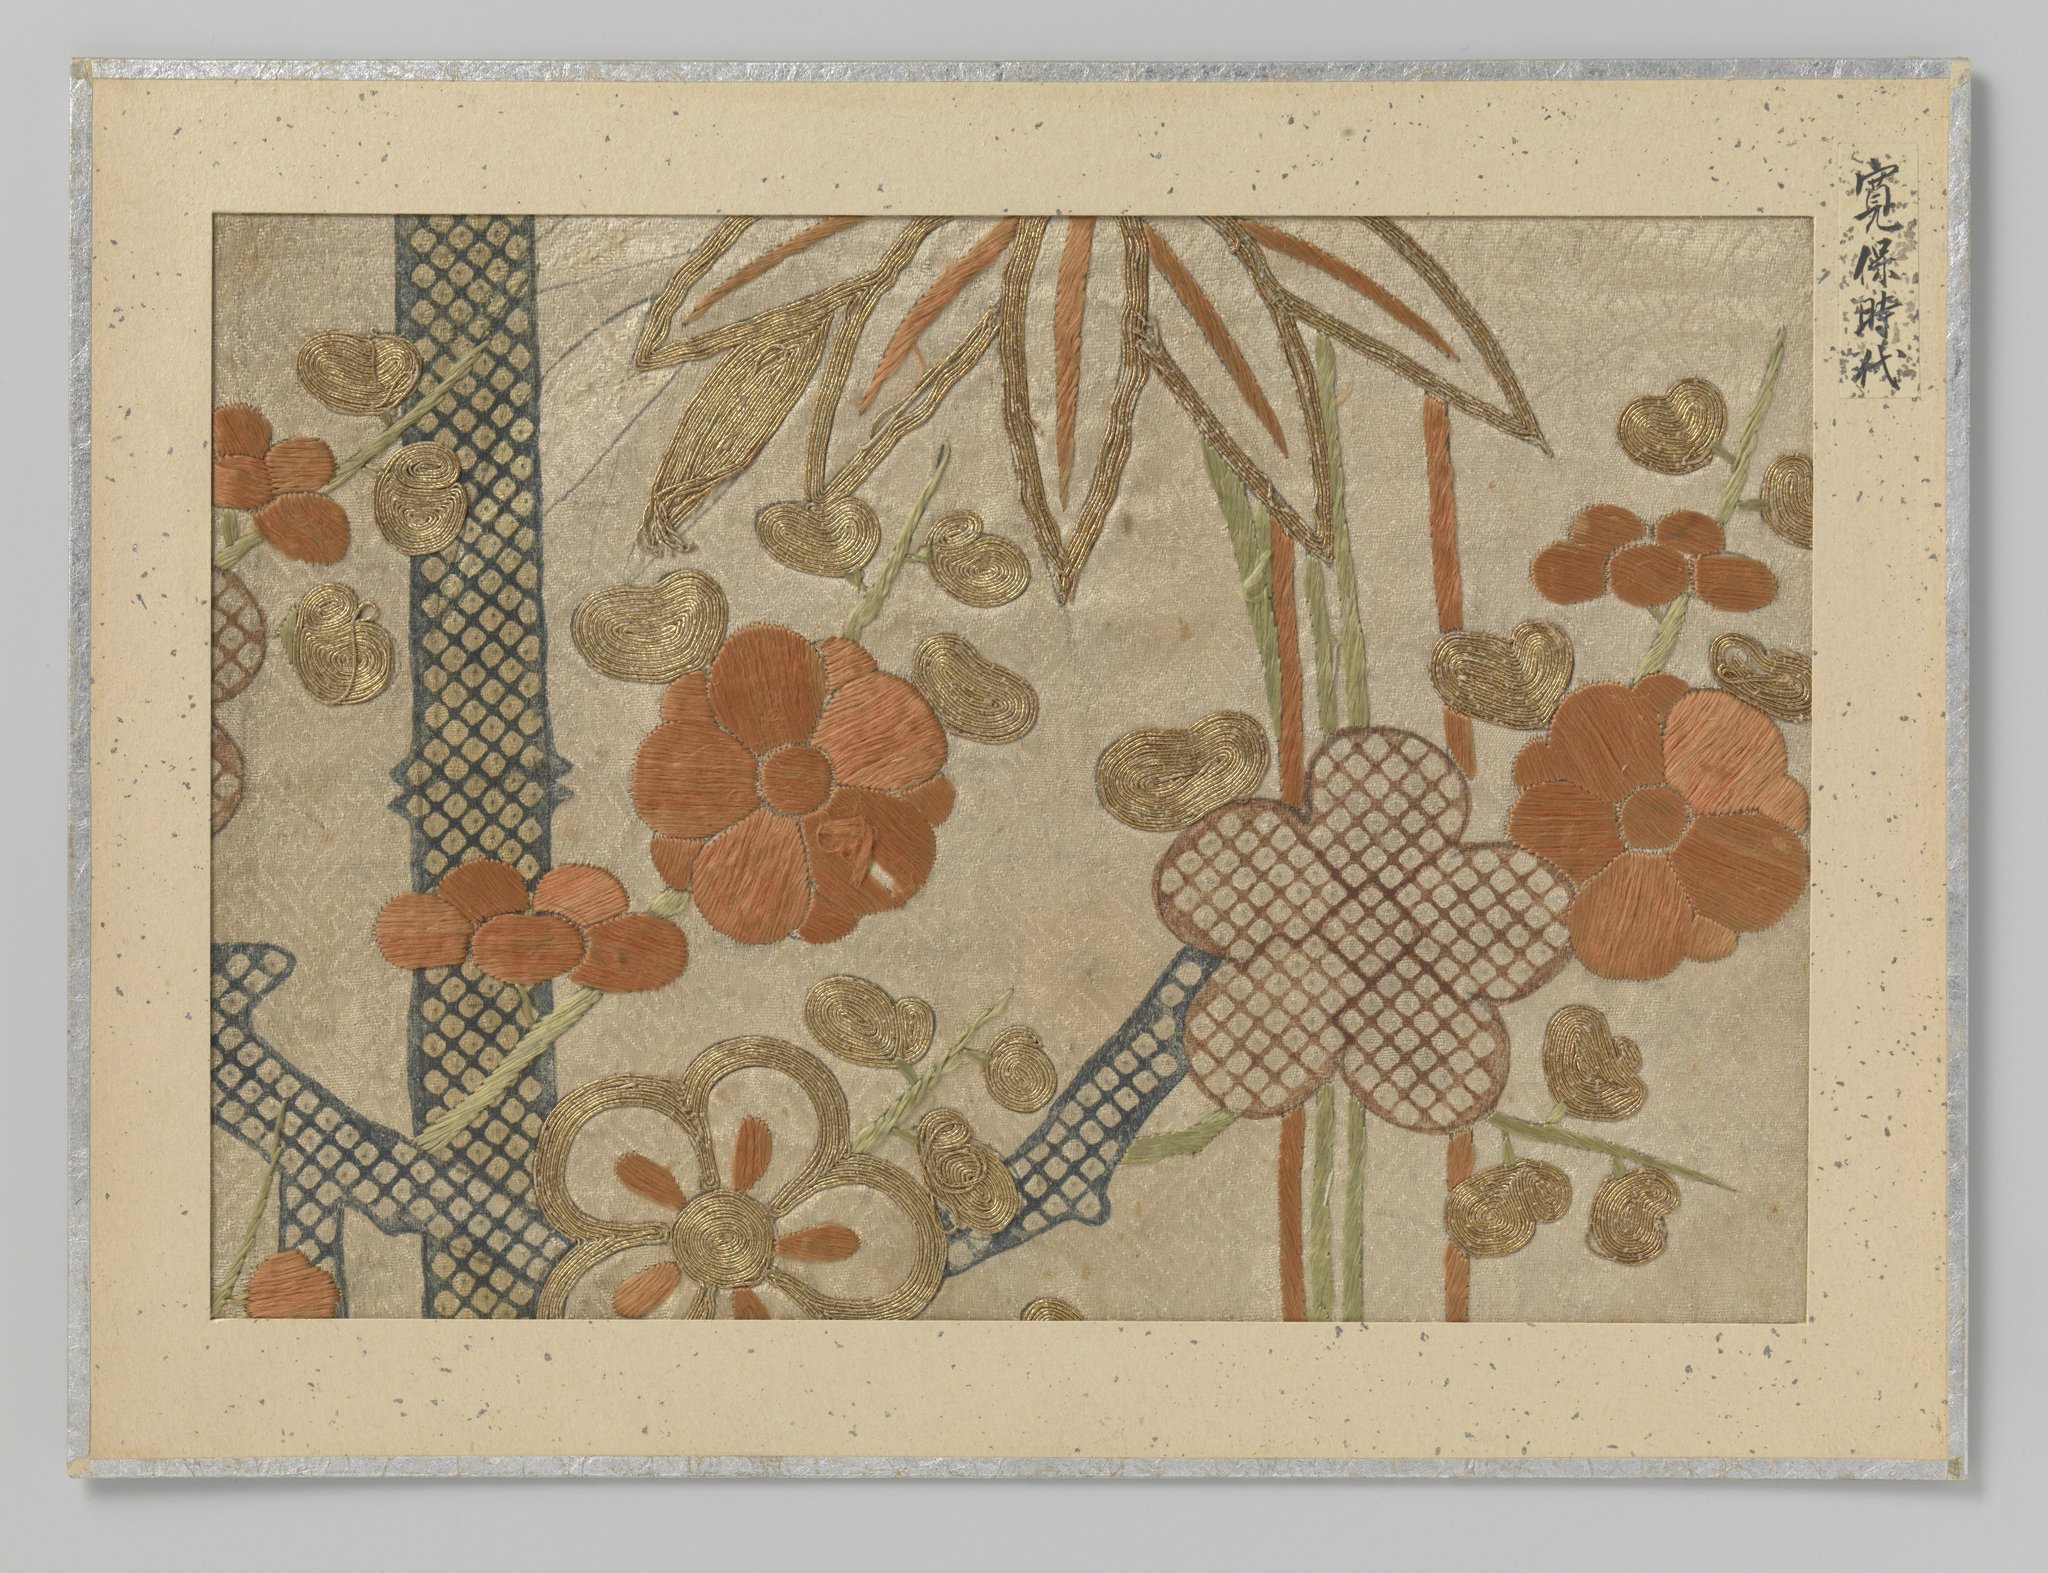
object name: fragment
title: Textielfragment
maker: Anonymous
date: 1741-1744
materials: silk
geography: japan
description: Textielfragment, borduursel en druk van bloemen en planten op beige achtergrond.